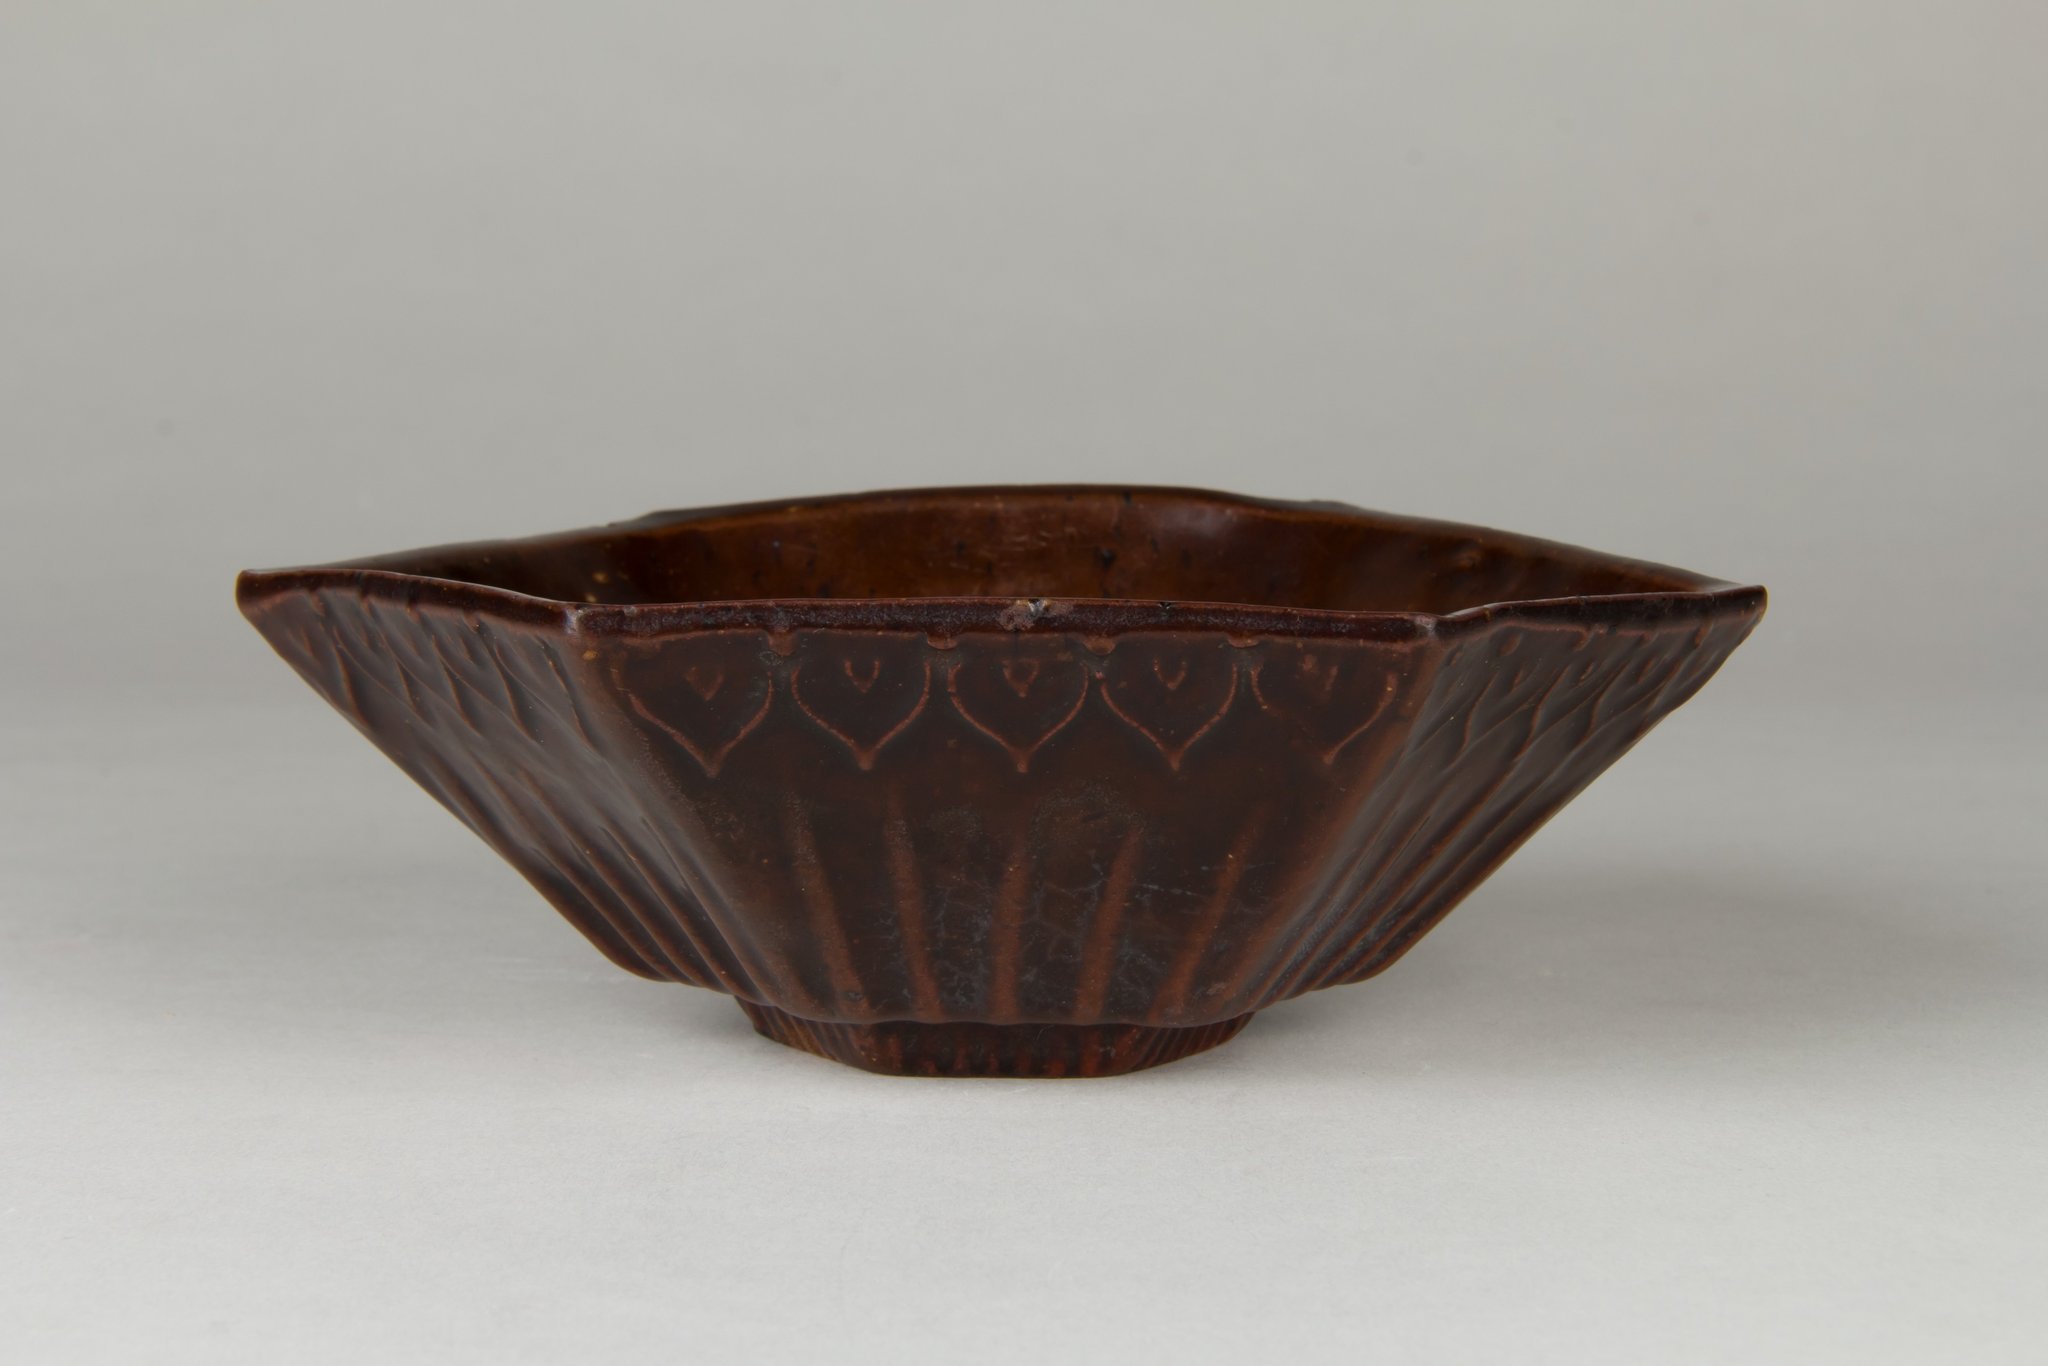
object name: dish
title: Hexagonal dish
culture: chinese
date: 1801-1900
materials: glaze, stoneware